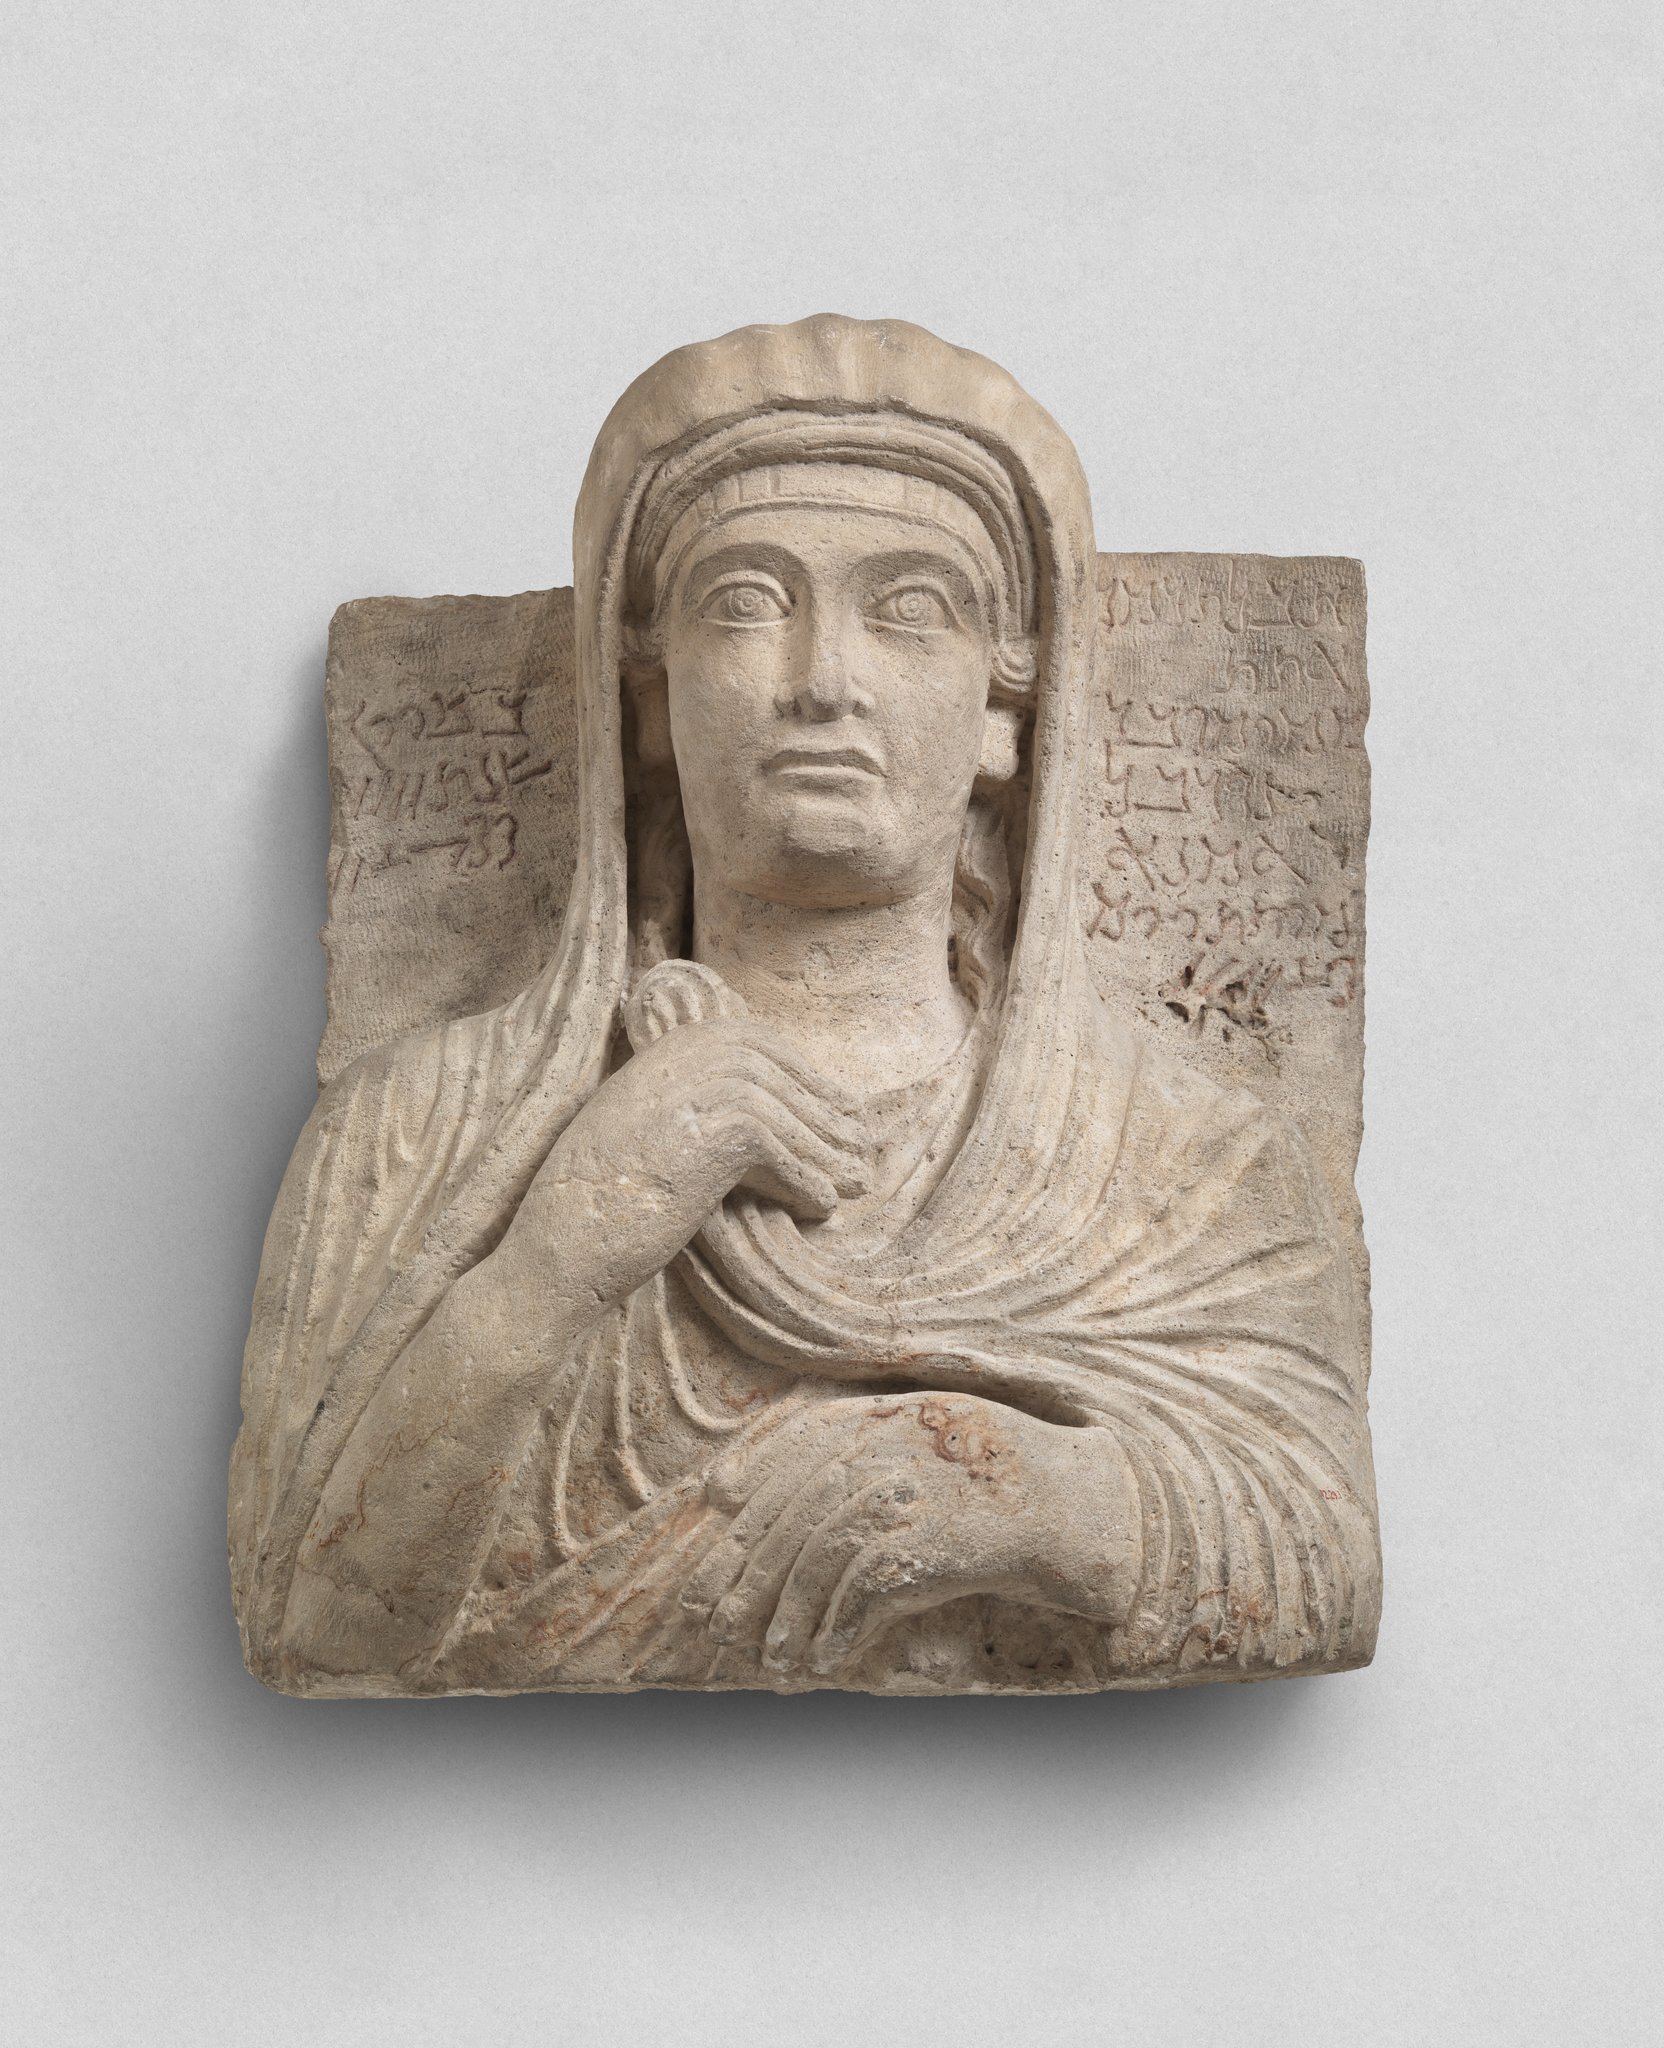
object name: funerary relief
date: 148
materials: limestone, paint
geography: syria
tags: portraits,women